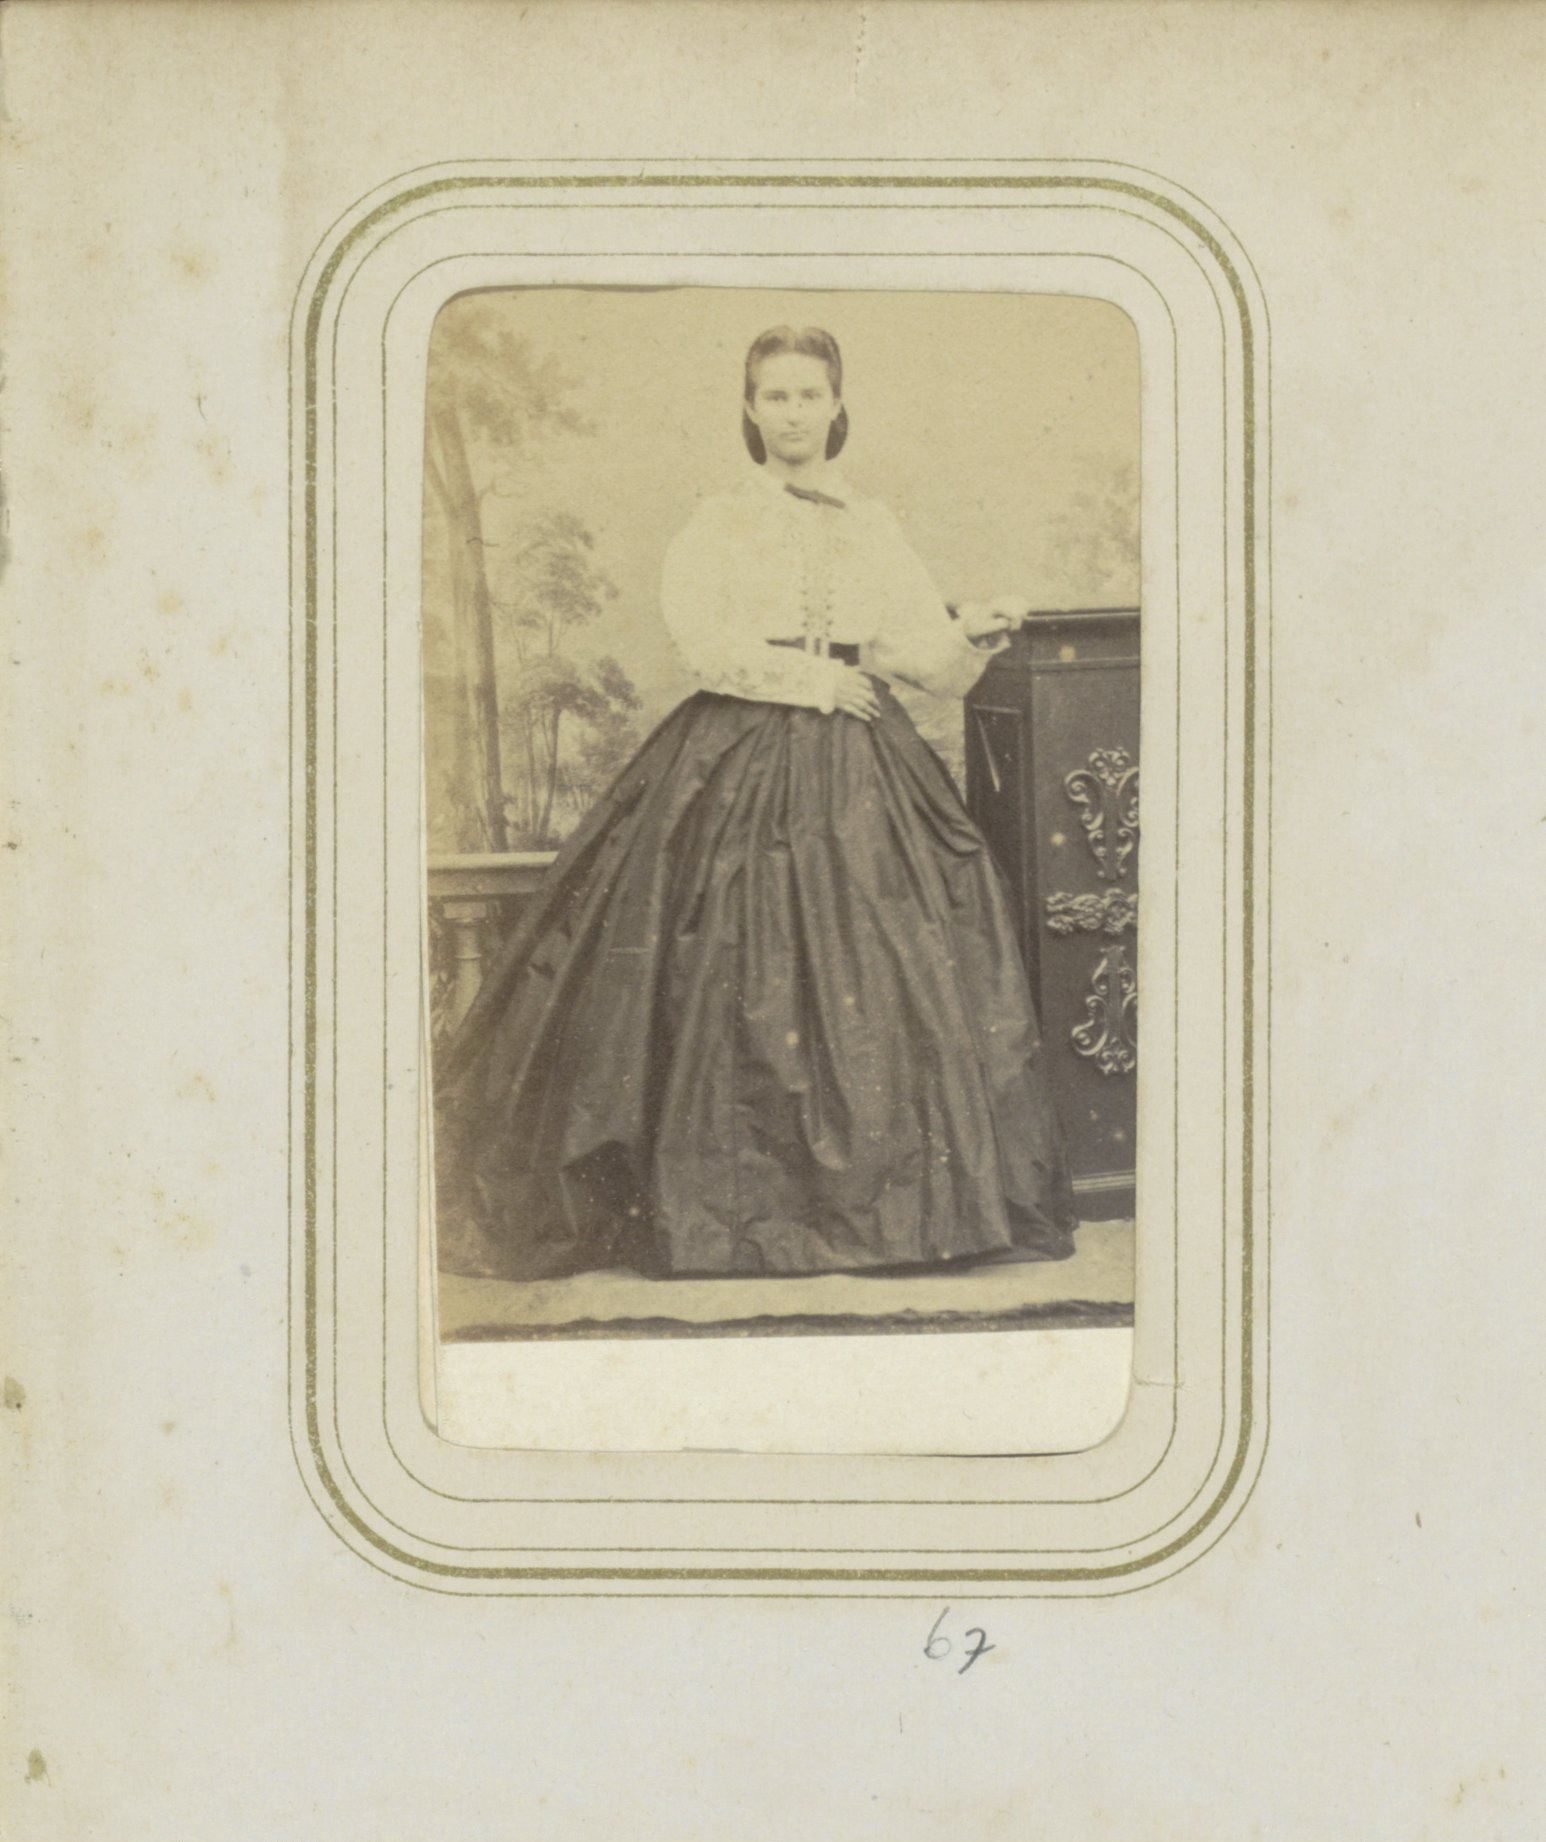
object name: carte de visite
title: Portret van een vrouw in een wijde rok en een witte blouse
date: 1860-1880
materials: cardboard, photographic support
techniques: albumen print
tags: studio requisites ~ photographer, clothing for the upper part of the body: blouse (+ women's clothes), historical persons, skirt (+ women's clothes), family, relationship, descent, hairdress, netherlands, dutch east indies, the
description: Onderdeel van Familiealbum van H.W.F. Ligtenberg en L.M. Swart met 149 foto's en cartes-de-visite.